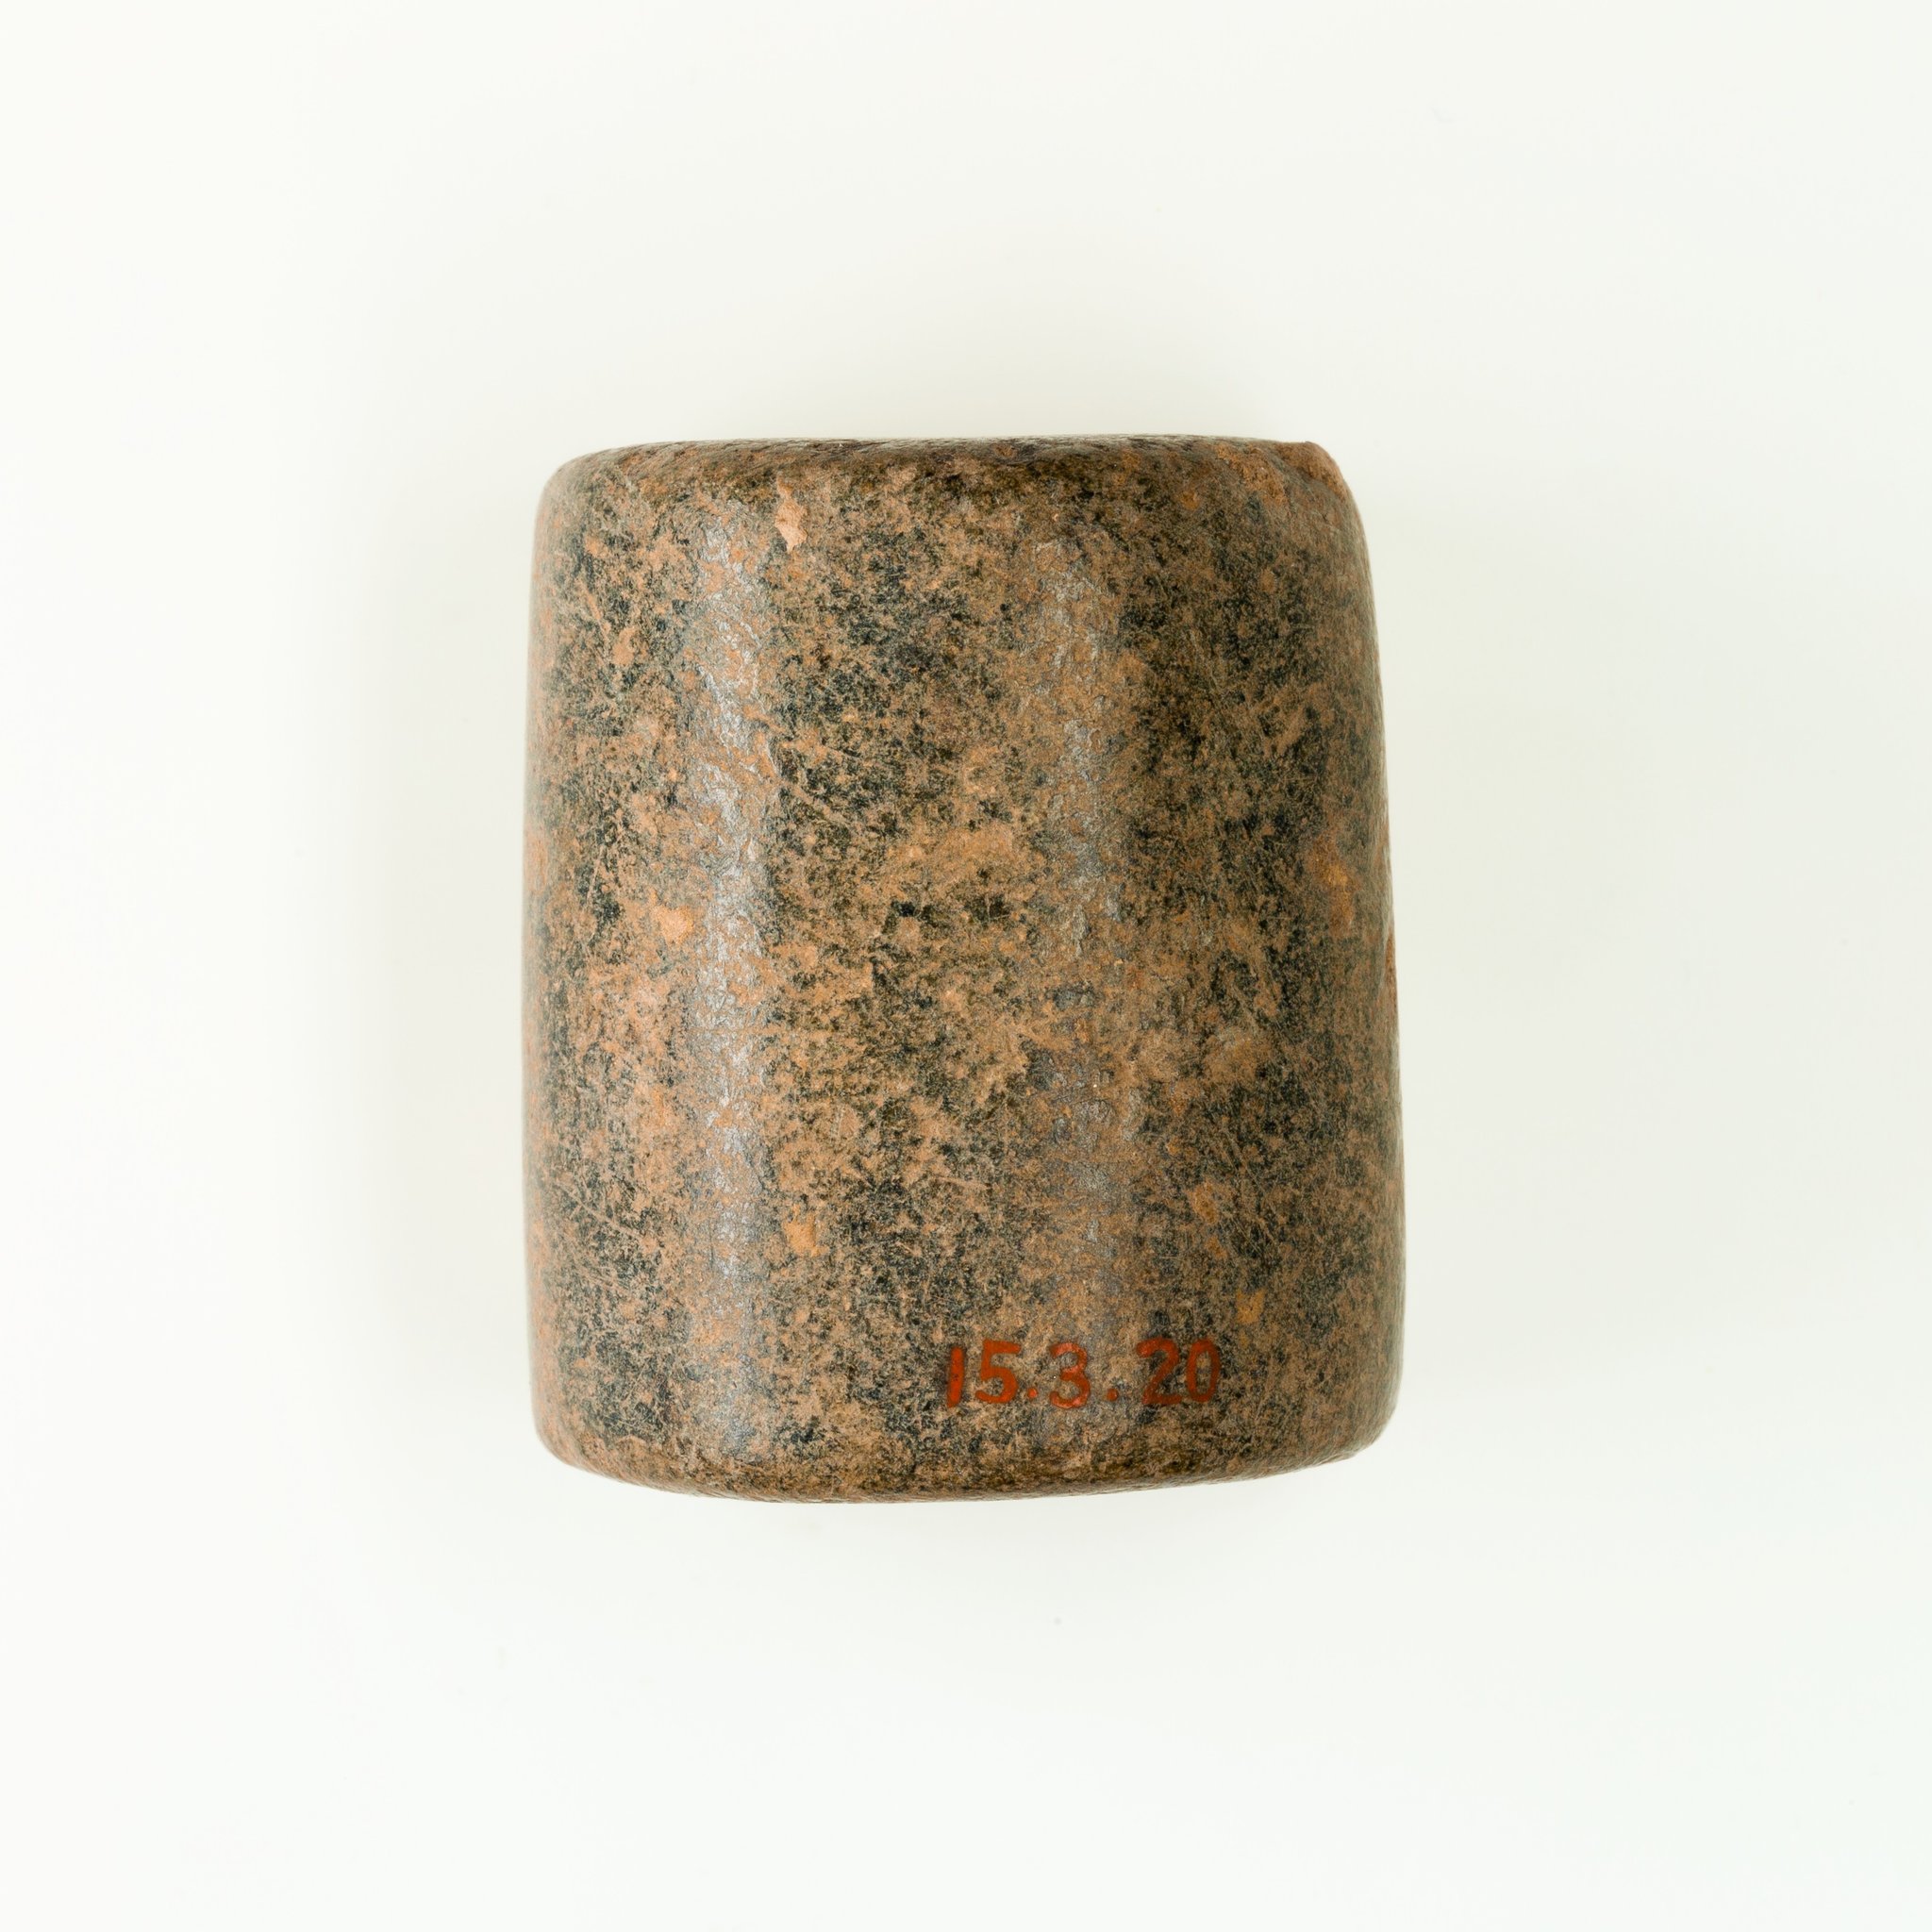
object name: weight, 5 deben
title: Weight of 5? debens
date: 1981-1640 BCE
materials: stone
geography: egypt